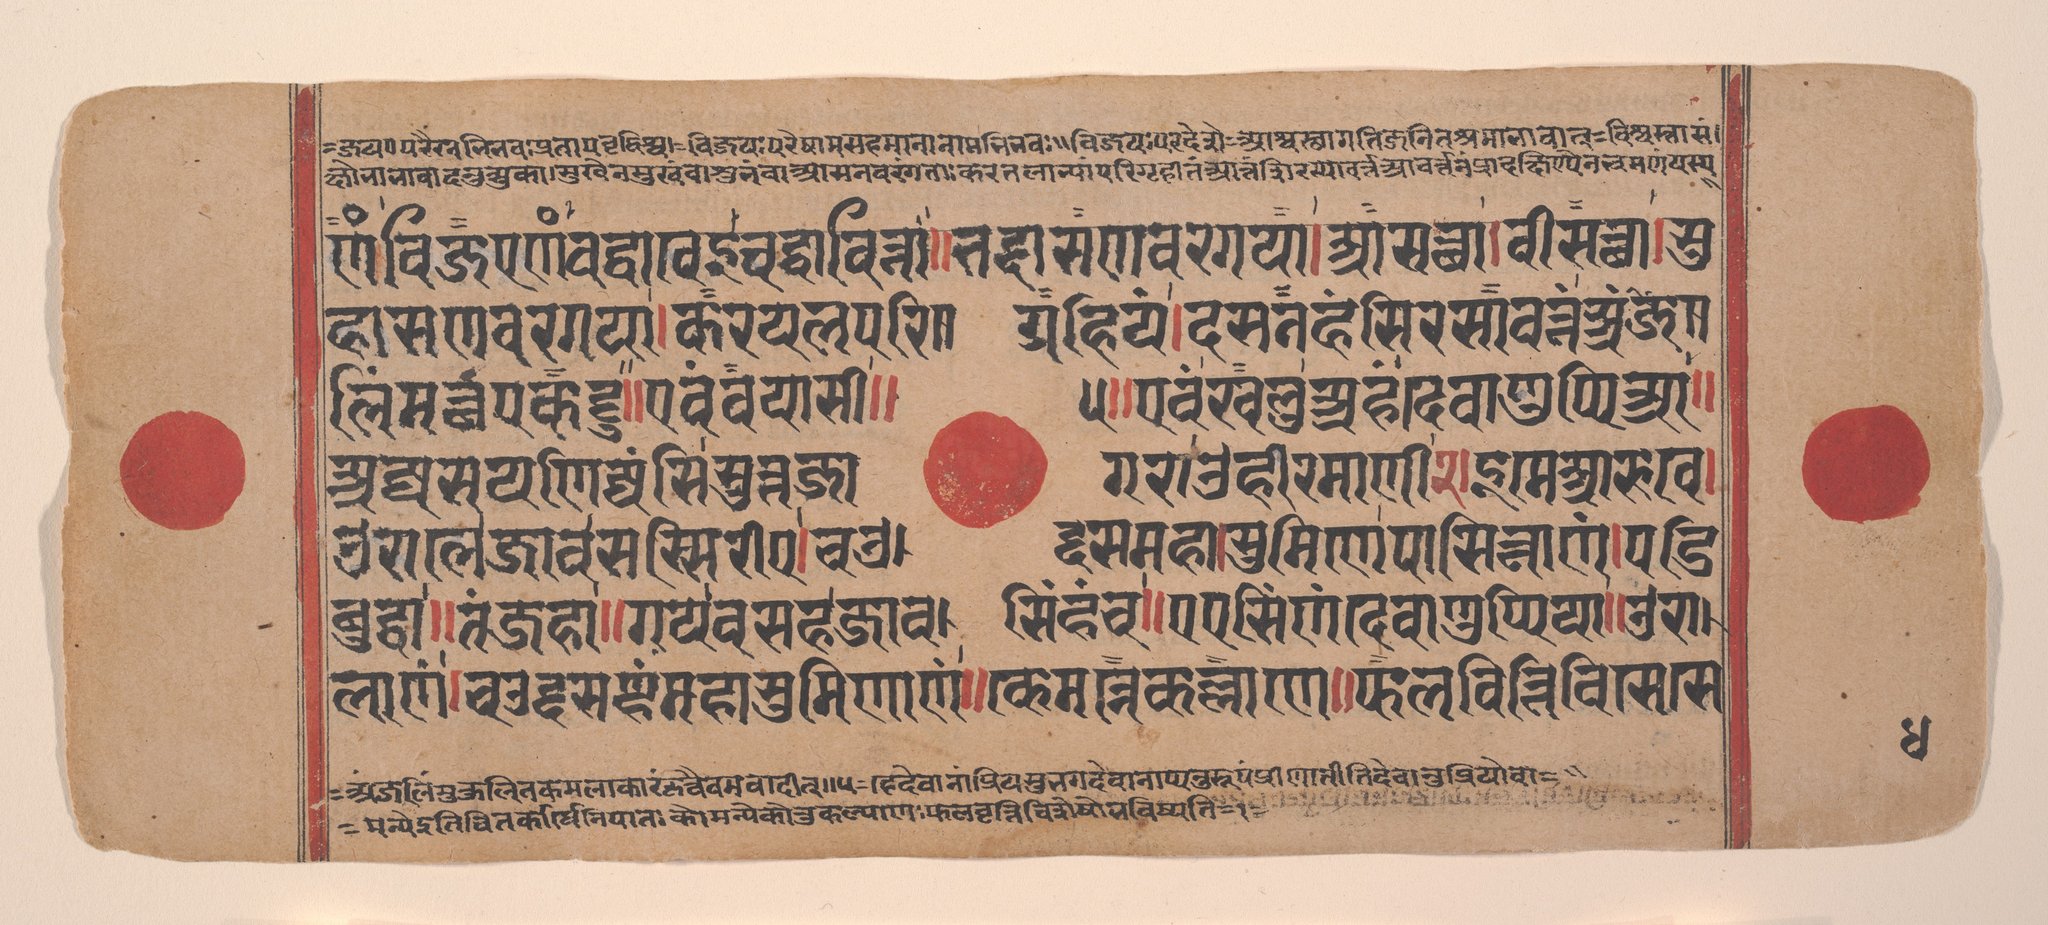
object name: folio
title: Page from a Dispersed Kalpa Sutra (Jain Book of Rituals)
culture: indian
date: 1401-1500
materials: gold, ink, paper, watercolor